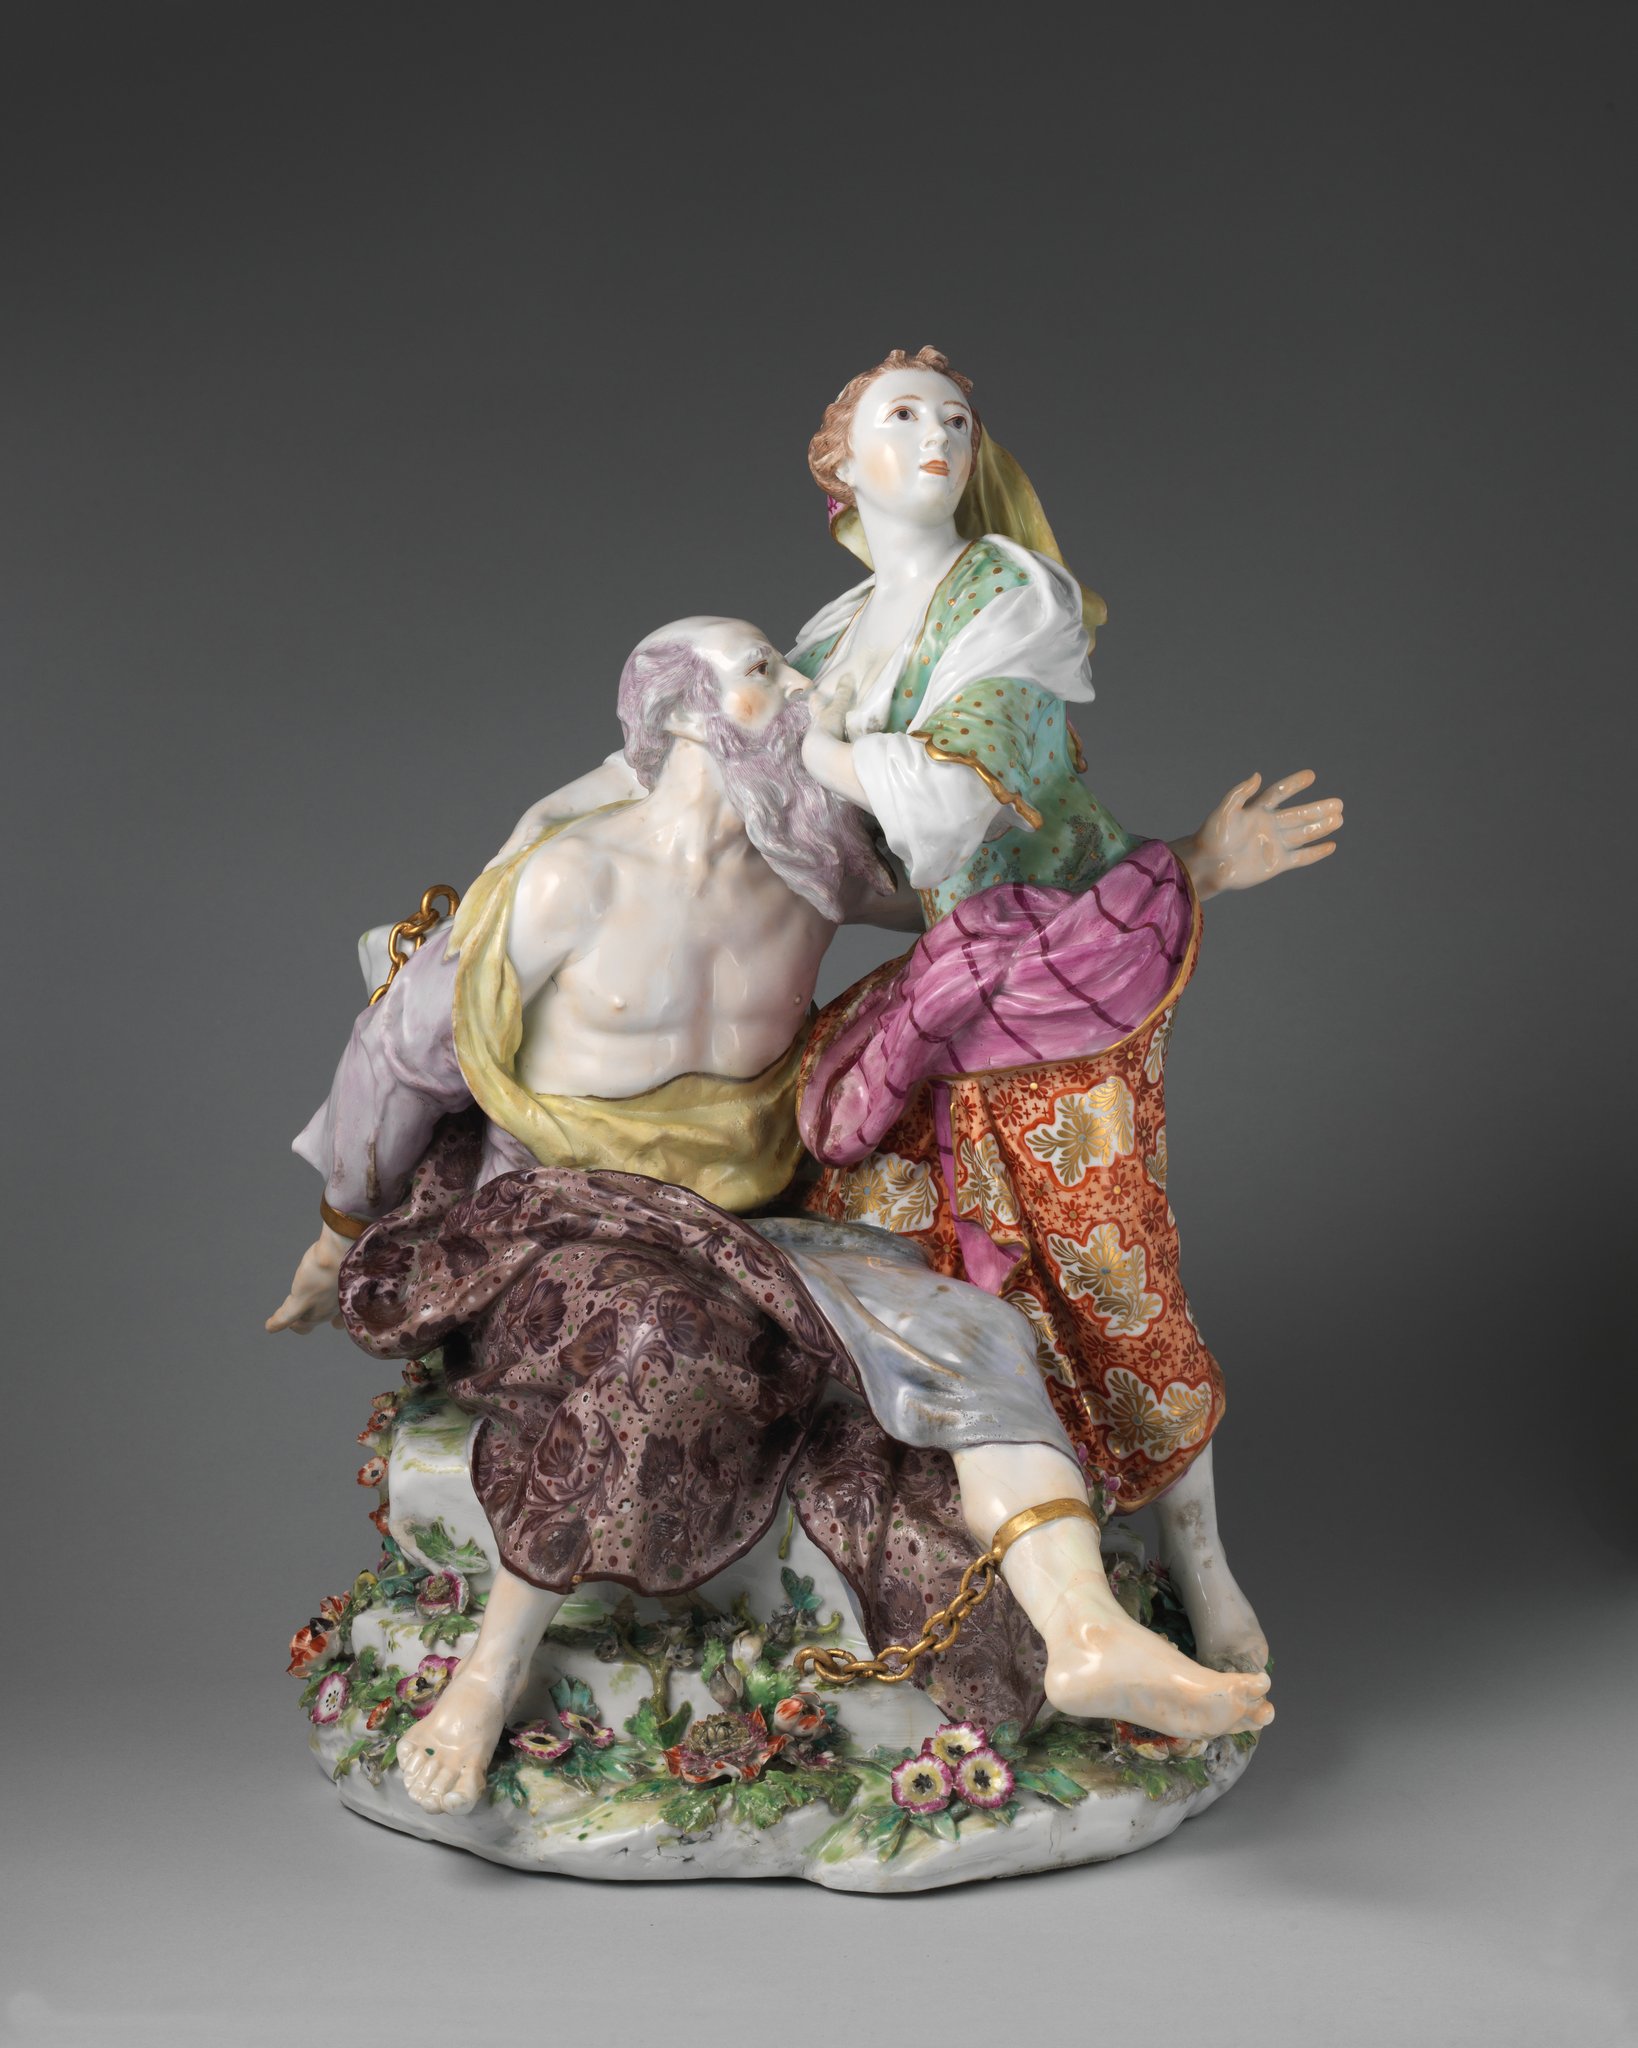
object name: figure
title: The Roman Charity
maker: chelsea porcelain manufactory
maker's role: factory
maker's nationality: british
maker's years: 1744-1784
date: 1769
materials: soft paste porcelain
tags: prisoners,men,women,flowers